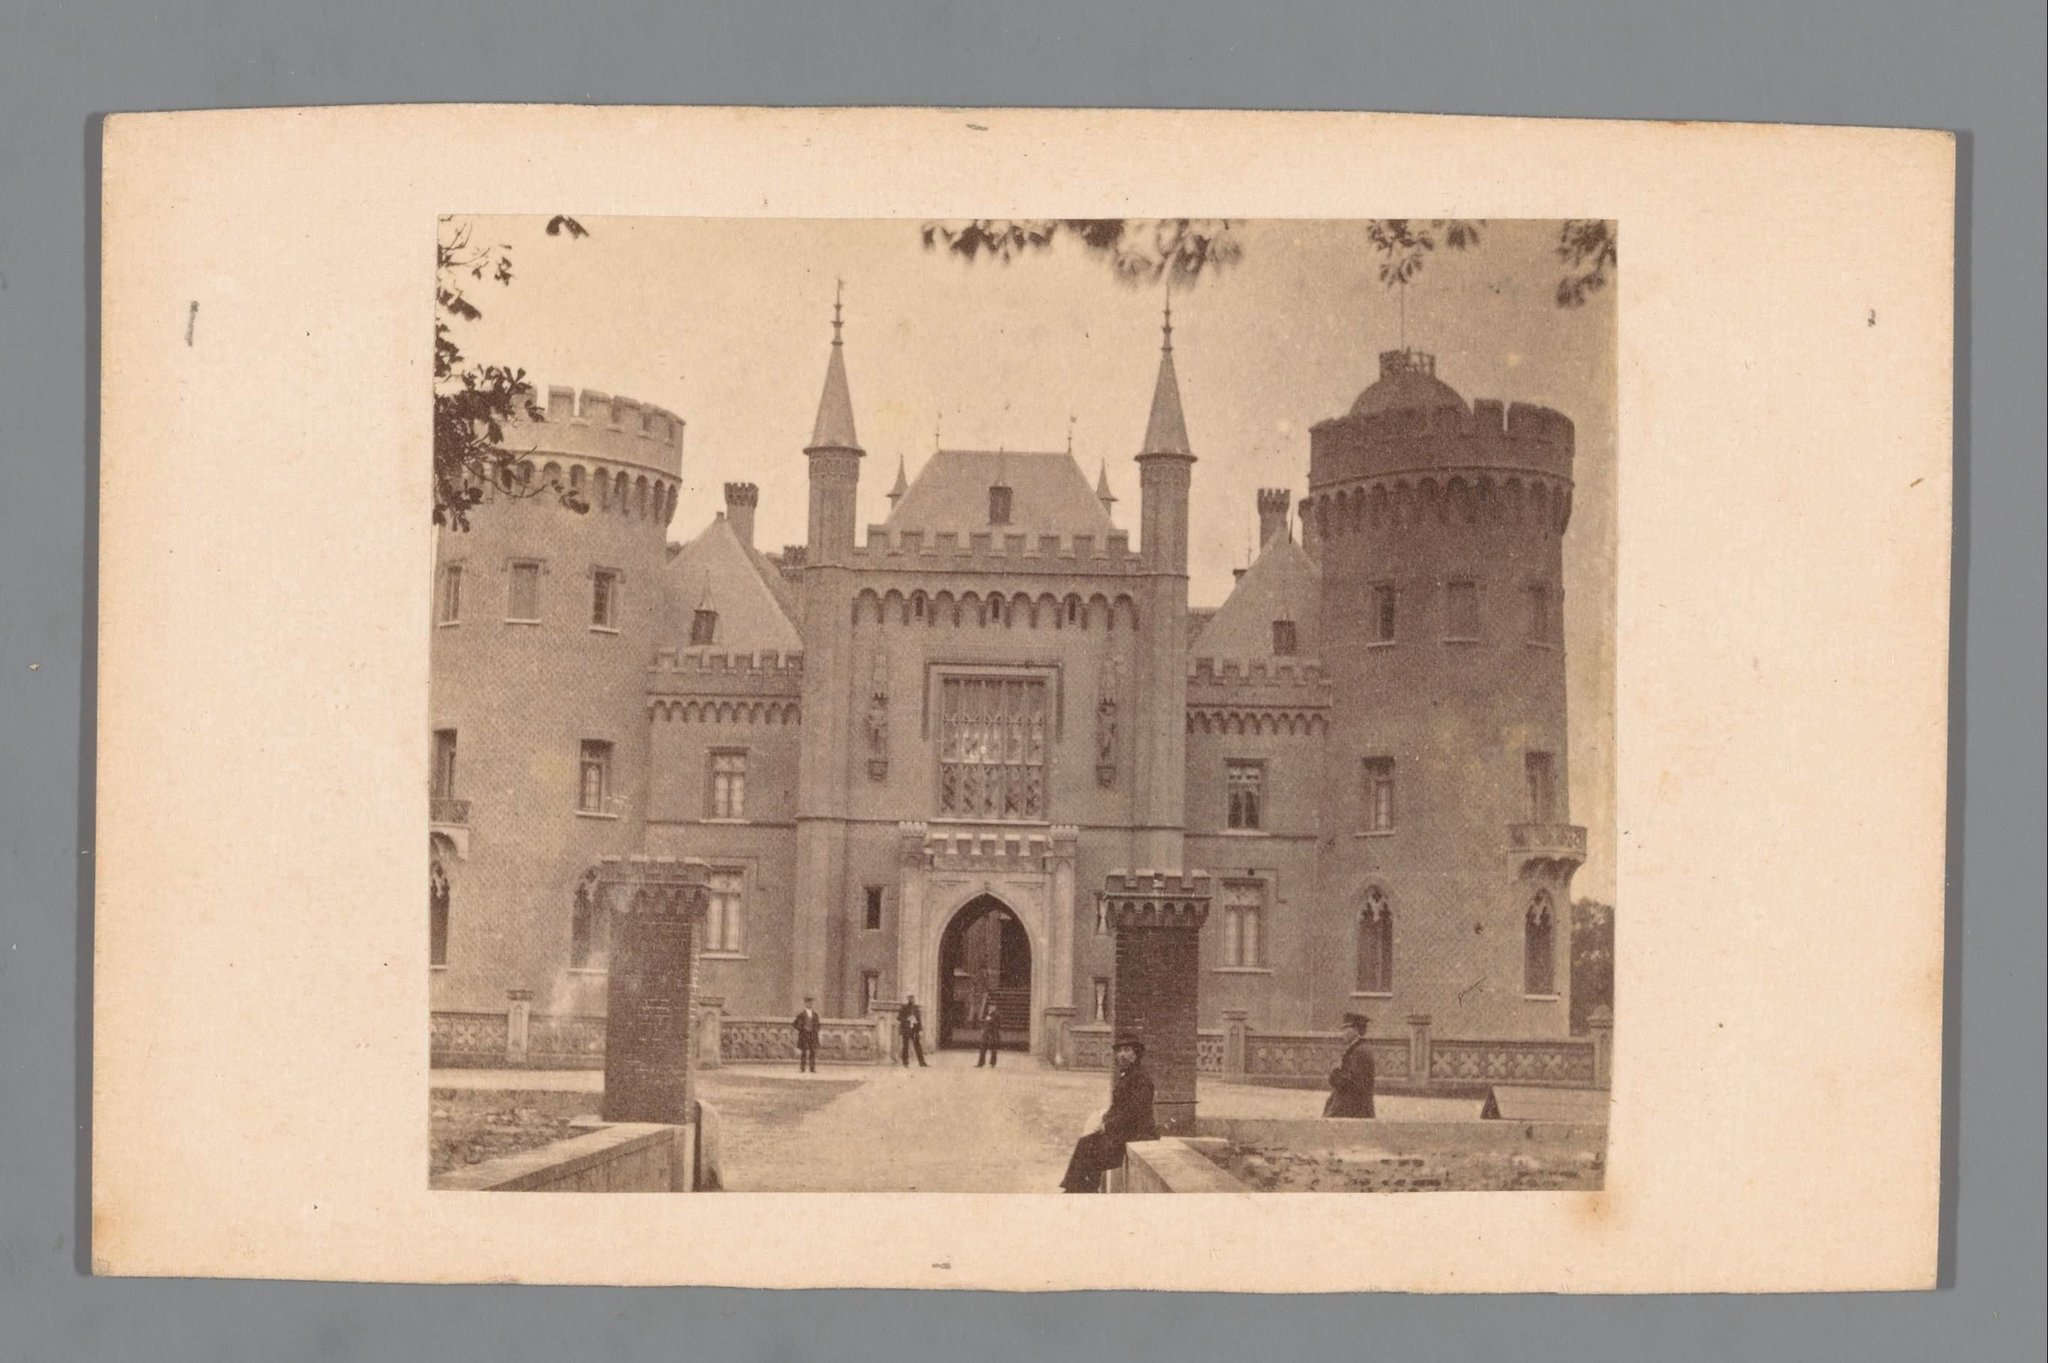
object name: photograph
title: Gezicht op Schloss Moyland in Bedburg-Hau, Duitsland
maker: Anonymous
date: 1850-1900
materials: cardboard, photographic support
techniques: albumen print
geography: bedburg-hau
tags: castle